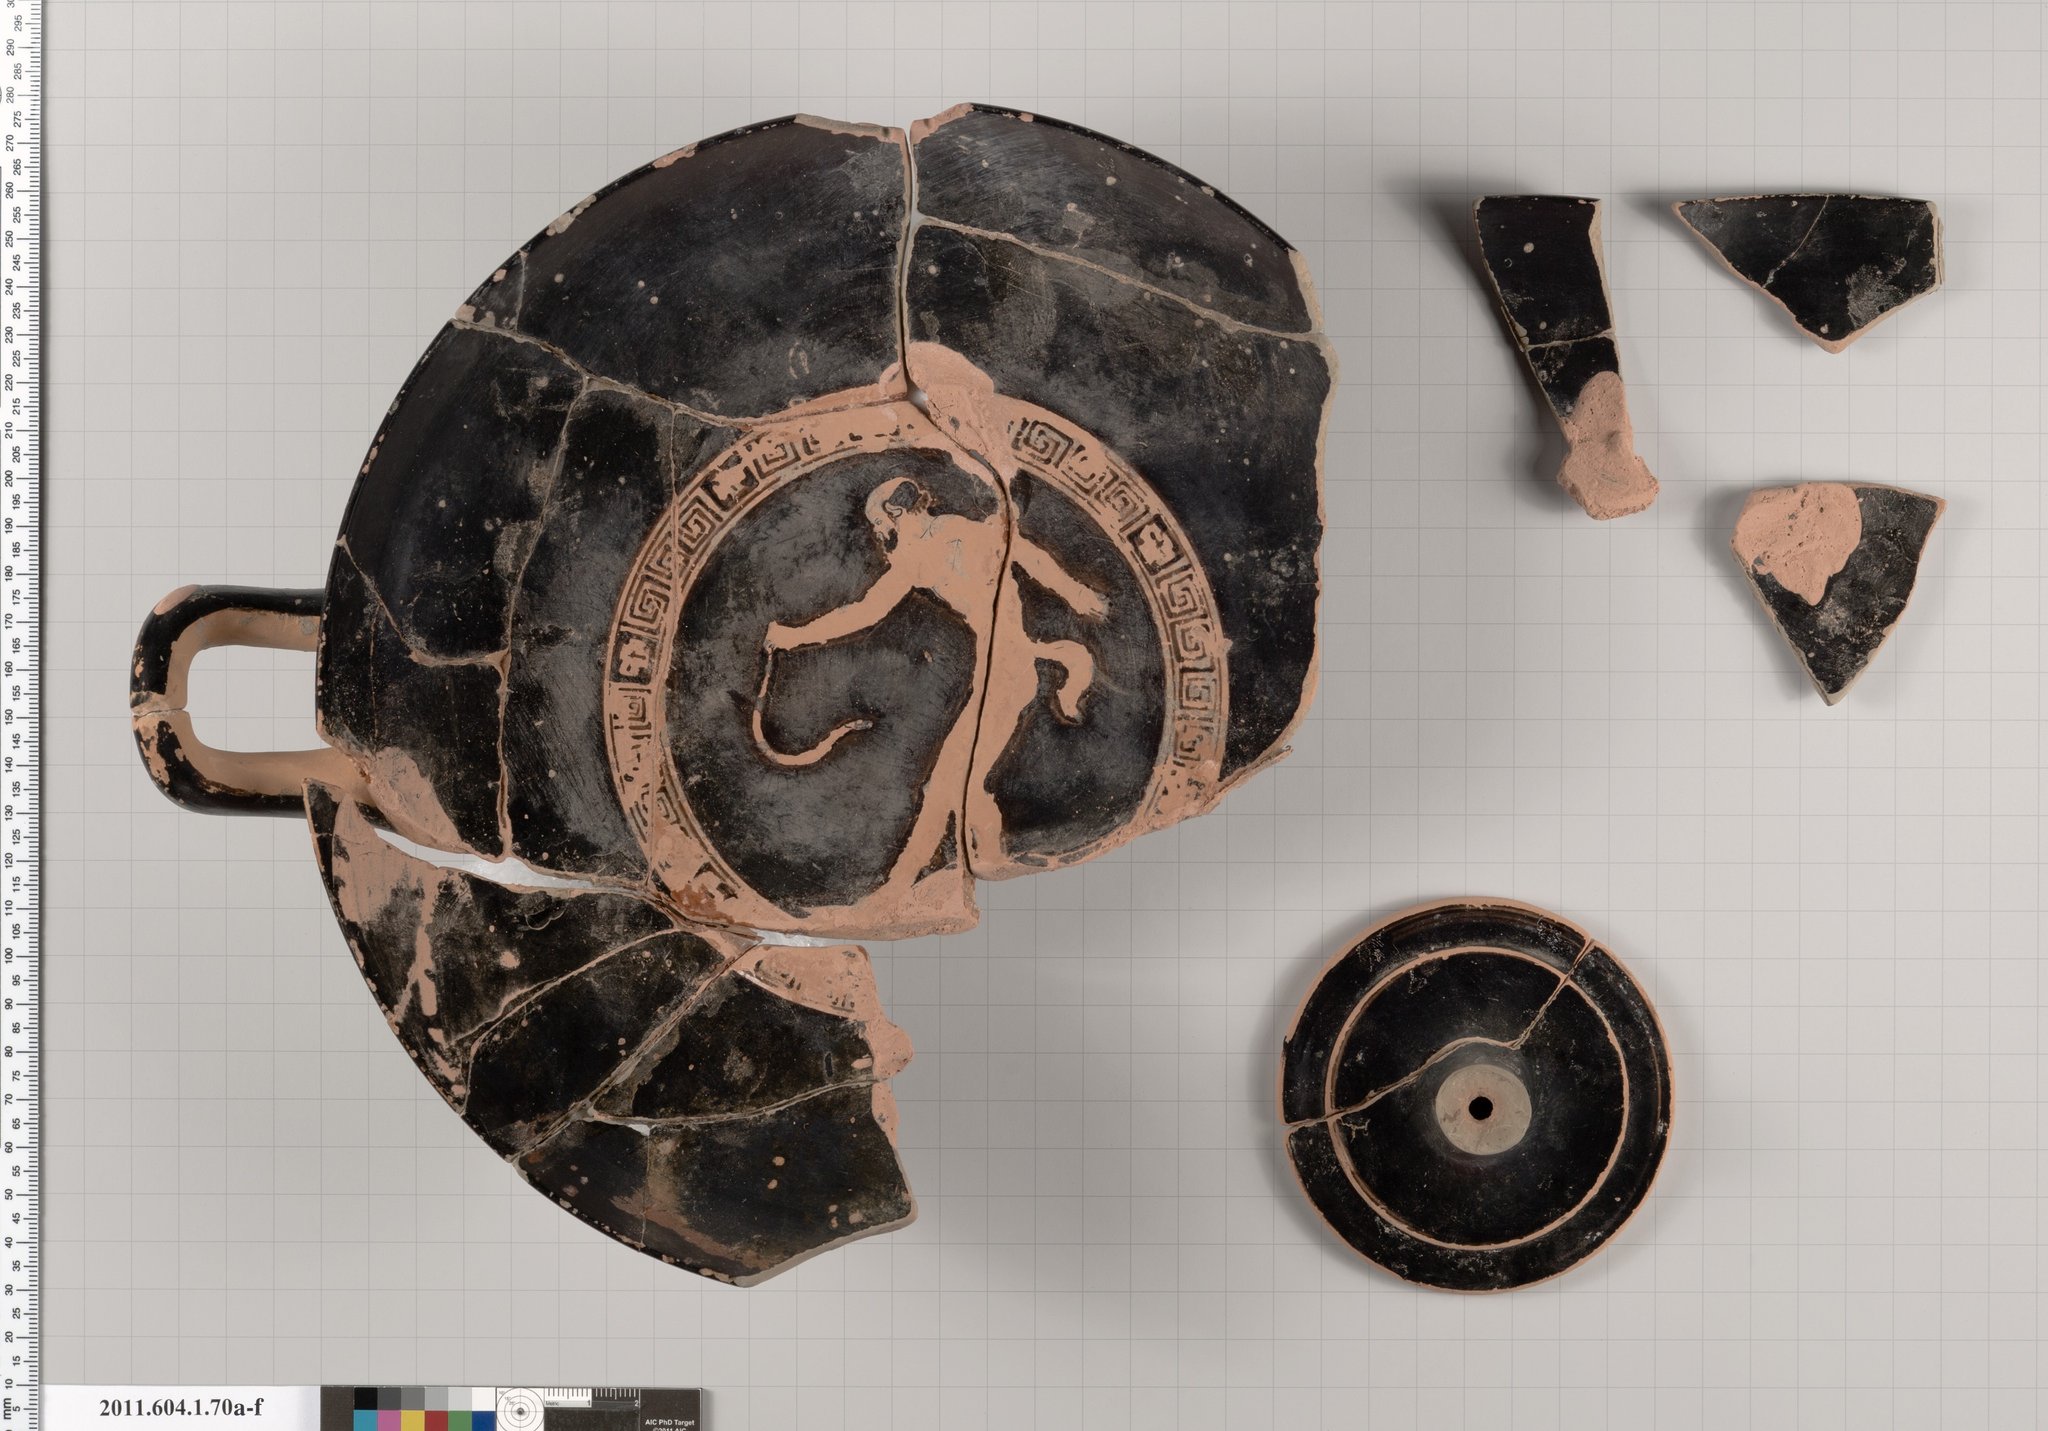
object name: kylix fragment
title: Terracotta fragments of a kylix (drinking cup)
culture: greek, attic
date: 470 BCE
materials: terracotta